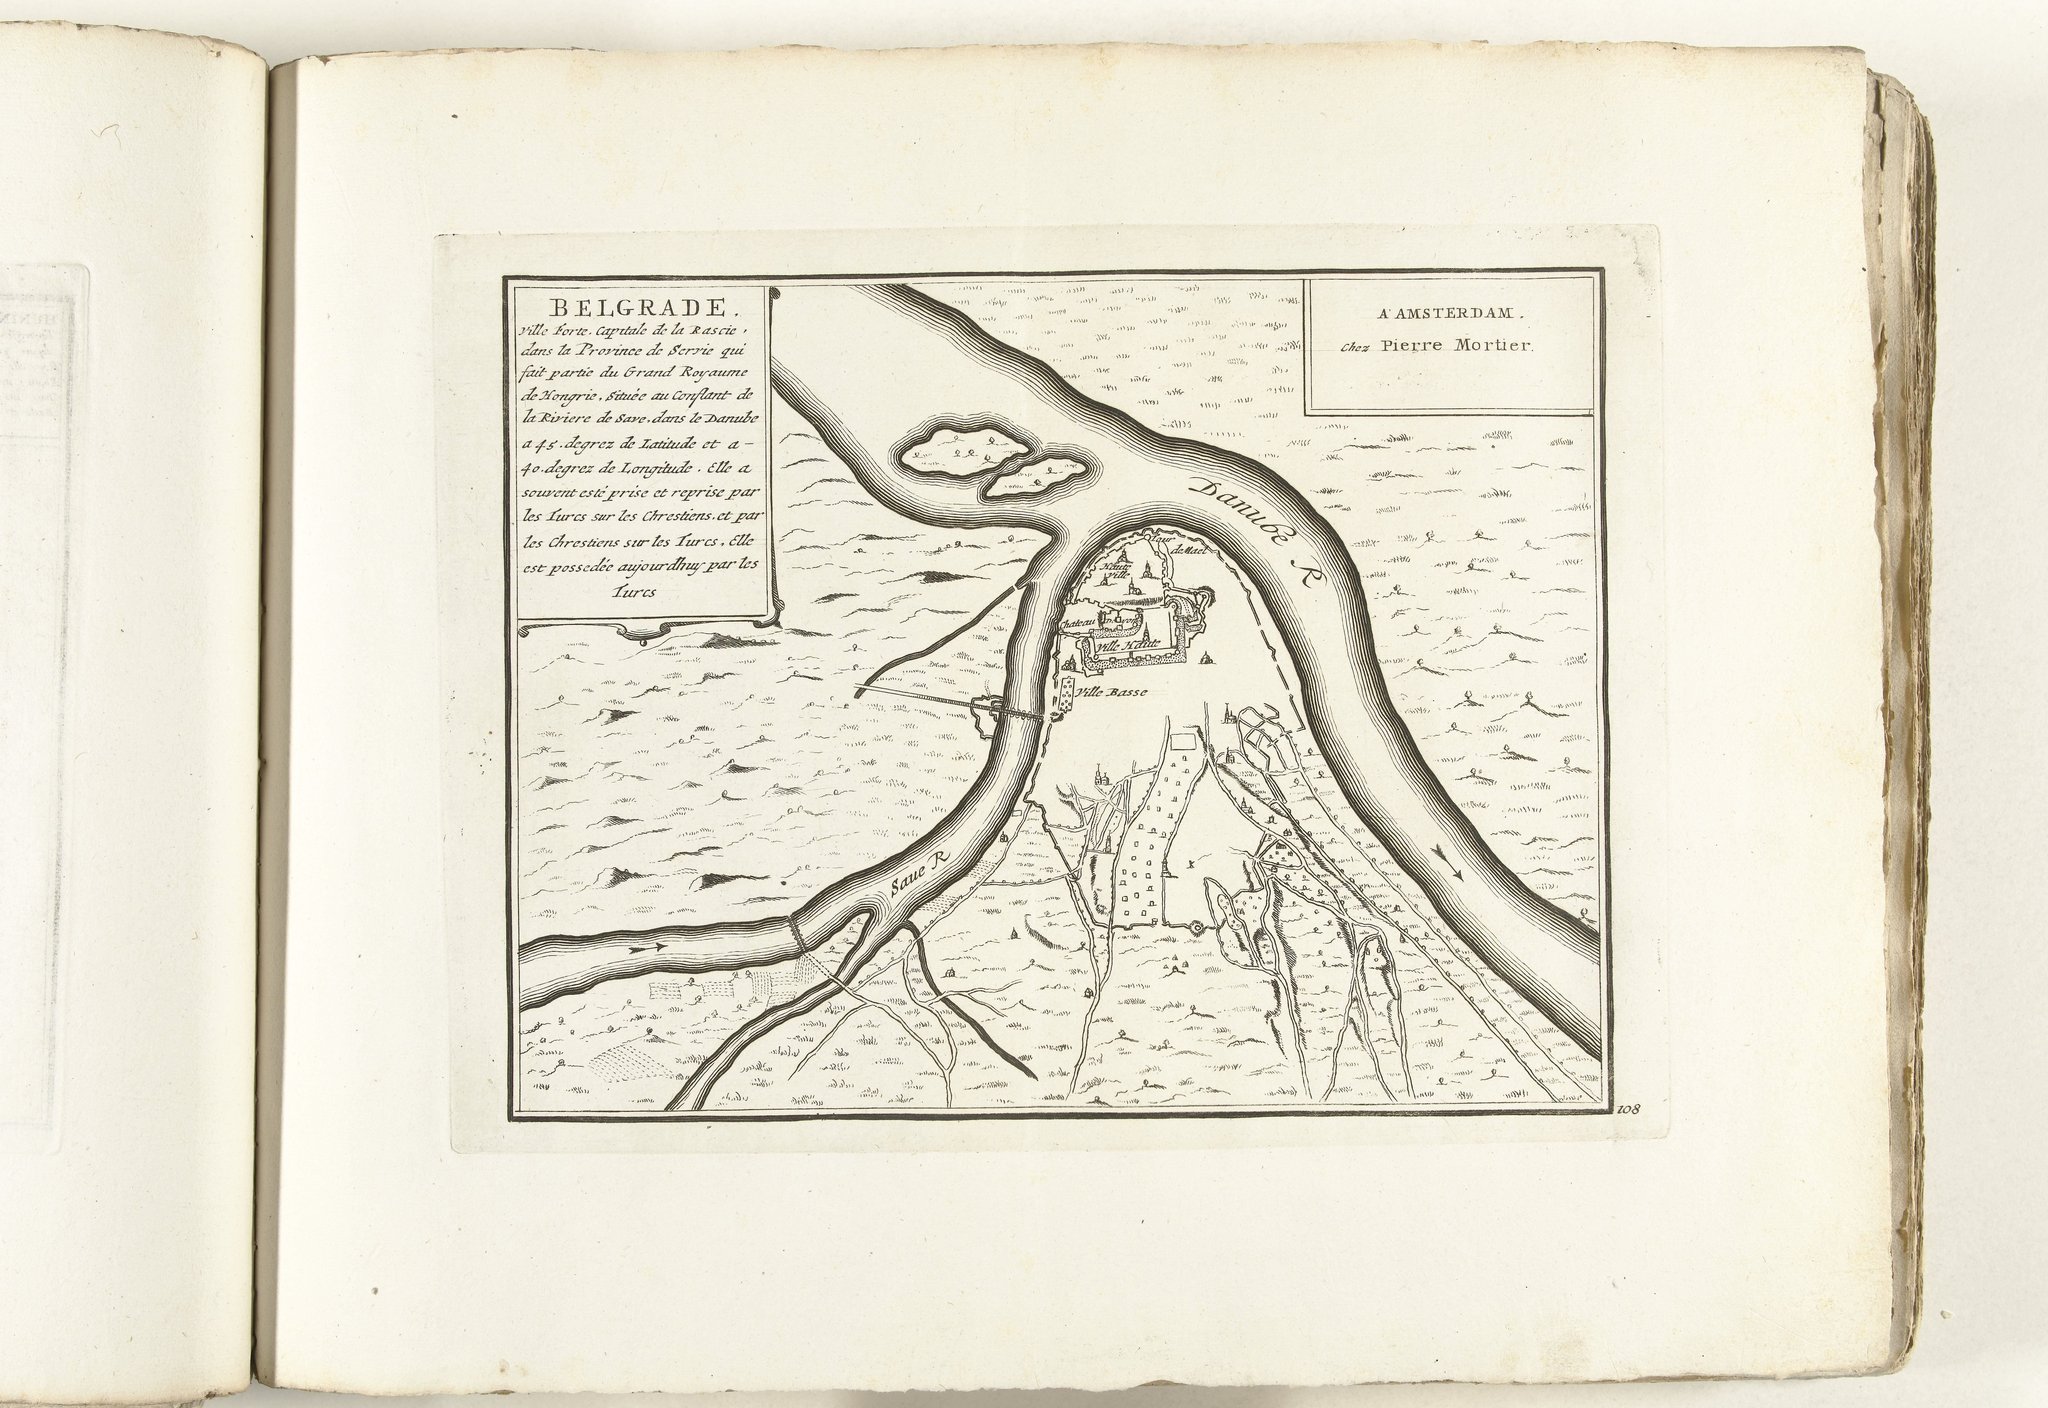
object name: map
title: Les Forces de l'Europe, Asie, Afrique et Amerique, ou description des principales villes avec leurs fortifications. Dessignées par les meilleurs ingenieurs, particulierement celles qui sont sous la domination de la France (...) et ornées de plusieurs superbes edifices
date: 1702-1703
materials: paper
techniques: etching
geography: northern netherlands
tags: fortress, maps of cities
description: Plattegrond van de versterkingen om de stad Belgrado. Plaat nr. 108 in het prentwerk bestaande in totaal uit 276 genummerde platen van vermaarde sterke steden en vestingen in het kader van de Spaanse Successieoorlog. Voor het merendeel zijn deze platen gekopieerd naar de anonieme Franse platen: in Les forces de l'Europe en in: Le theatre de la guerre, dans les Pays-Bas, beide oorspronkelijk uitgegeven door Nicolas de Fer te Parijs (1693-1697) in het kader van de Negenjarige Oorlog. Titel en opschriften in de plaat in het Frans.